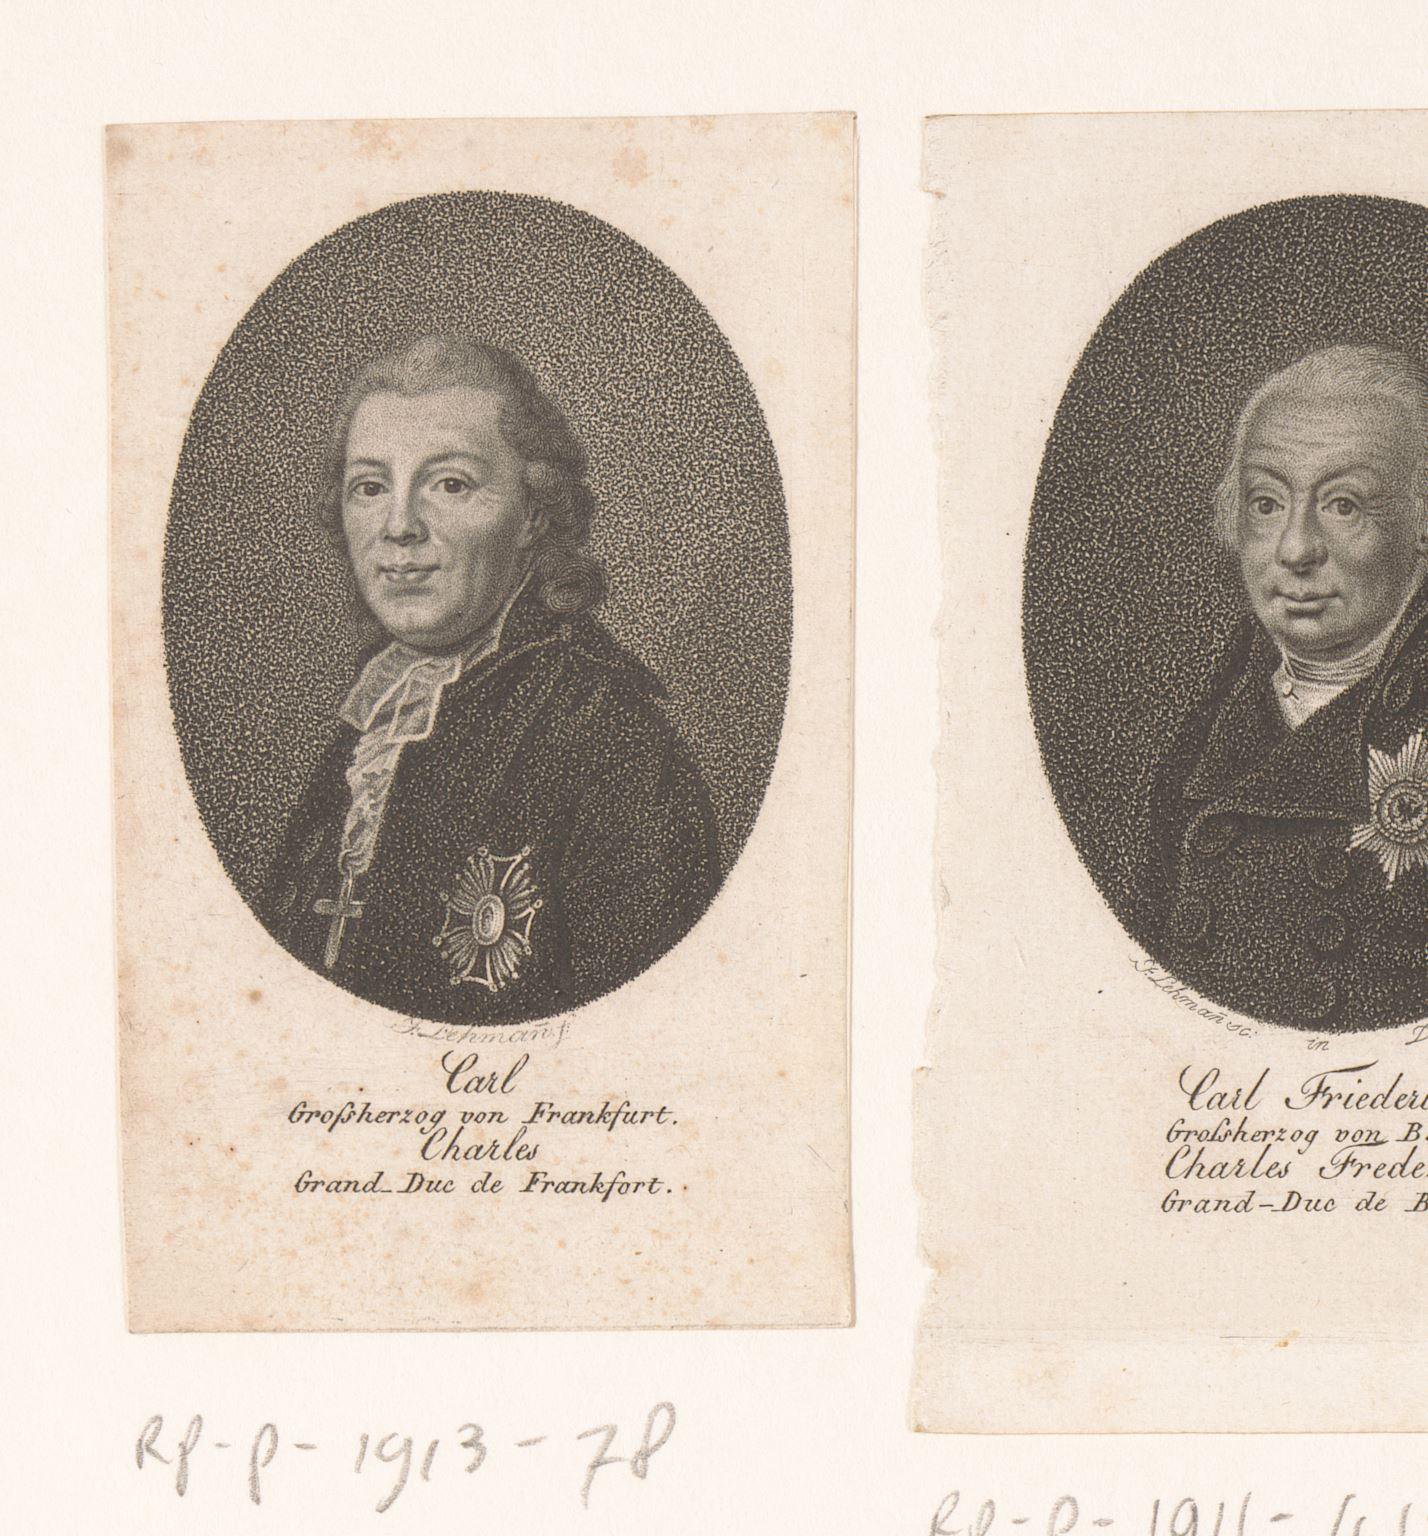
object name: print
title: Portret van Carl, Grossherzog von Frankfurt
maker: friedrich leonhard lehmann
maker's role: print maker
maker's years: 1787-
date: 1797-1886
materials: paper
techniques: engraving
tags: historical persons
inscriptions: collector's mark: Lugt 2228